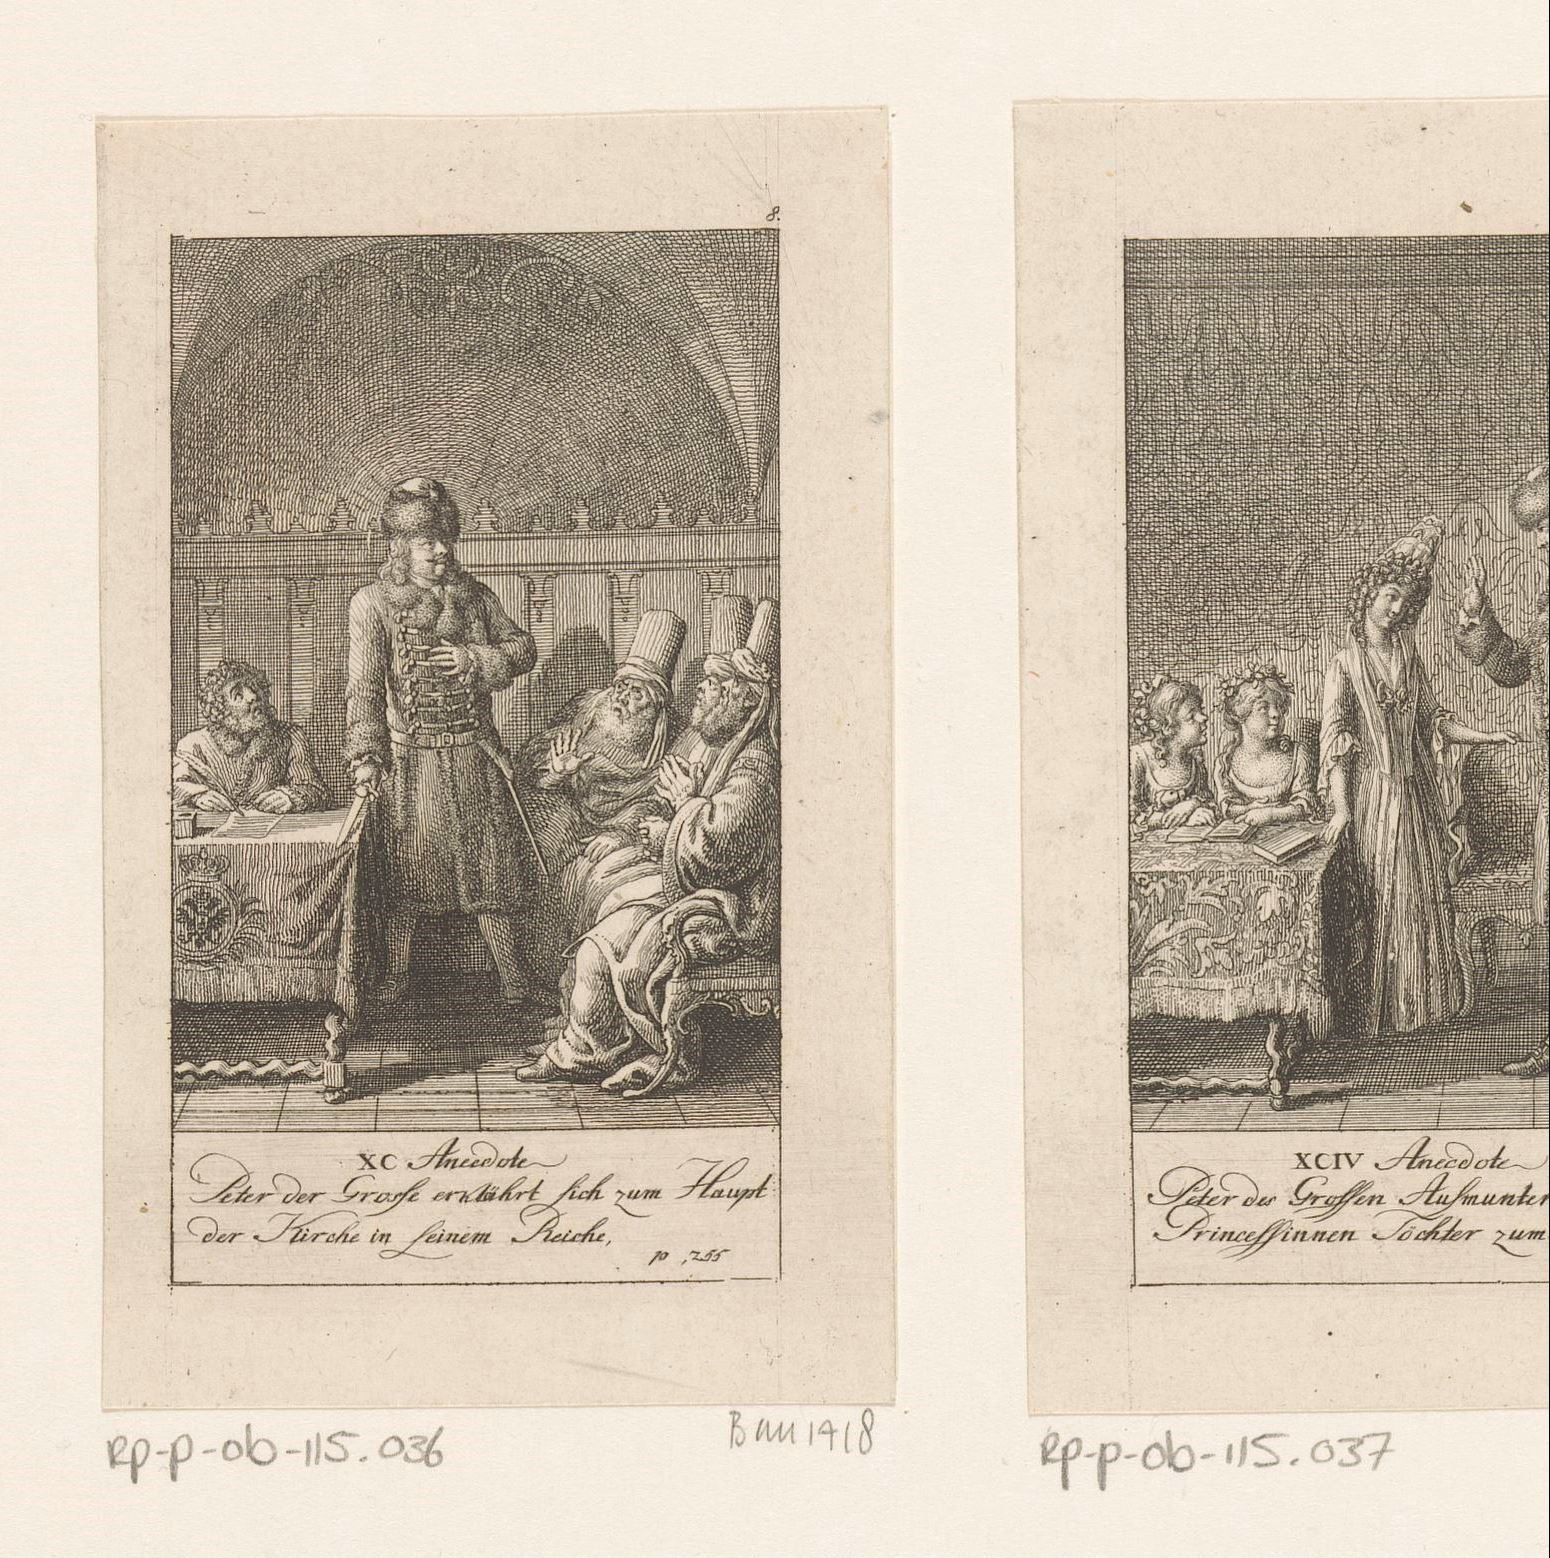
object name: book illustration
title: Peter de Grote voor de patriarchen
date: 1789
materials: paper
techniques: etching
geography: berlin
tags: peter i de grote (tsaar van rusland), russian orthodox church, history, emperor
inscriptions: collector's mark: Lugt 2228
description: Vervaardigd voor 'Anekdoten vom Peter dem Grossen'. Prent gebruikt voor: Goettinger Taschen Calender vom Jahr 1790. Göttingen: Johann Christoph Dietrich, [1789].